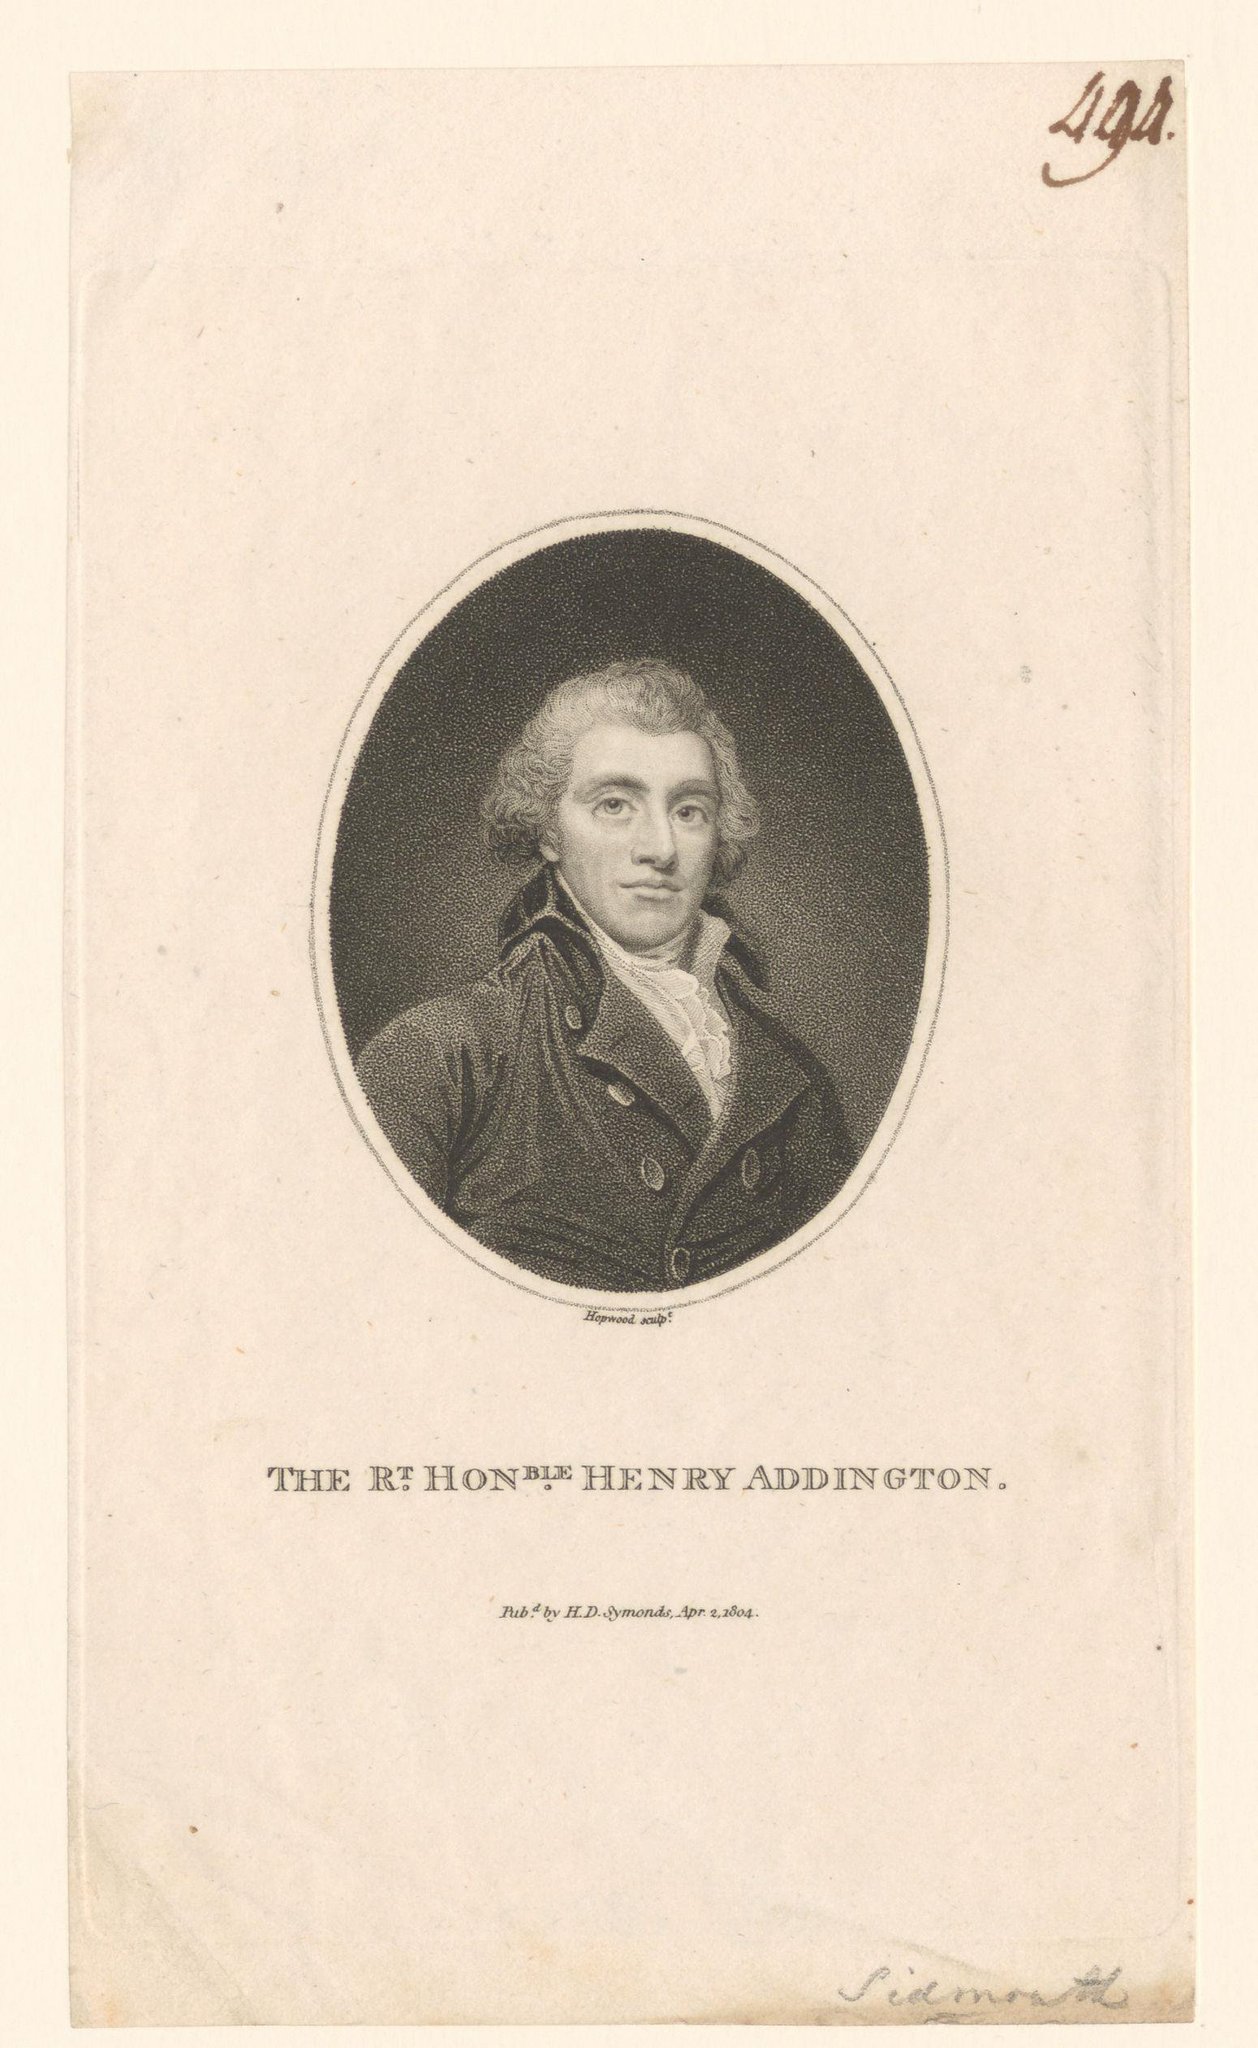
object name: print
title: The Rt. Honble. Henry Addington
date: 1804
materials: paper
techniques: engraving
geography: london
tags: historical persons, politician, e.g. party leader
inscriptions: collector's mark: Lugt 2228